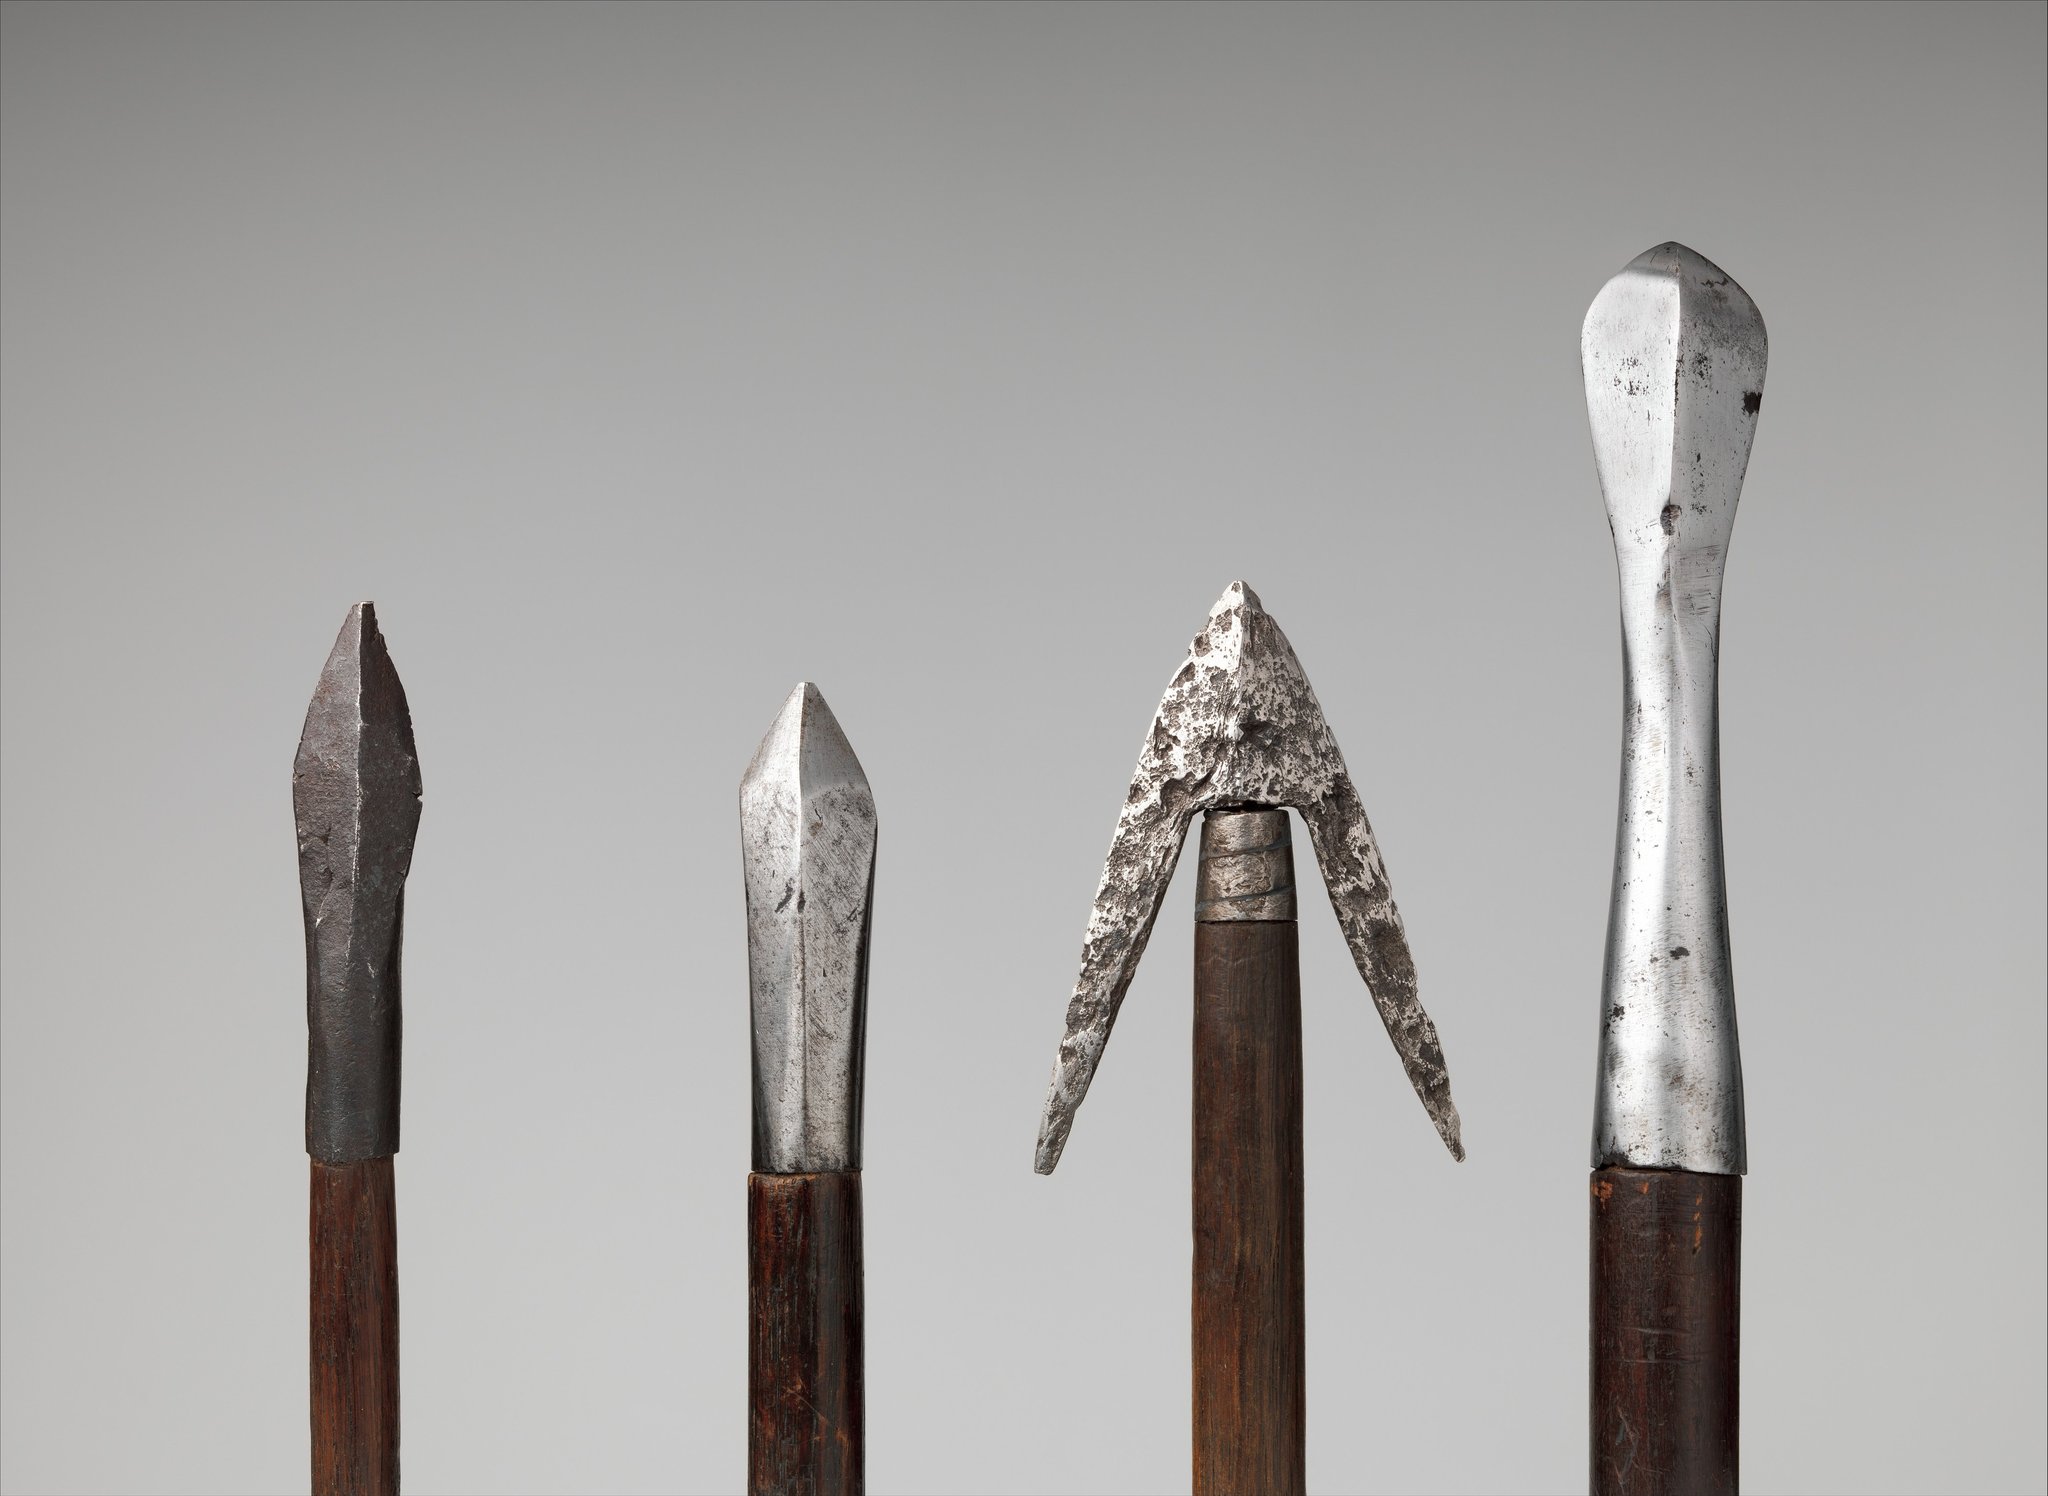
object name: six crossbow bolt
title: Twelve Crossbow Bolts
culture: central or western european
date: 1401-1700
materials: feather, leather, steel, wood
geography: switzerland